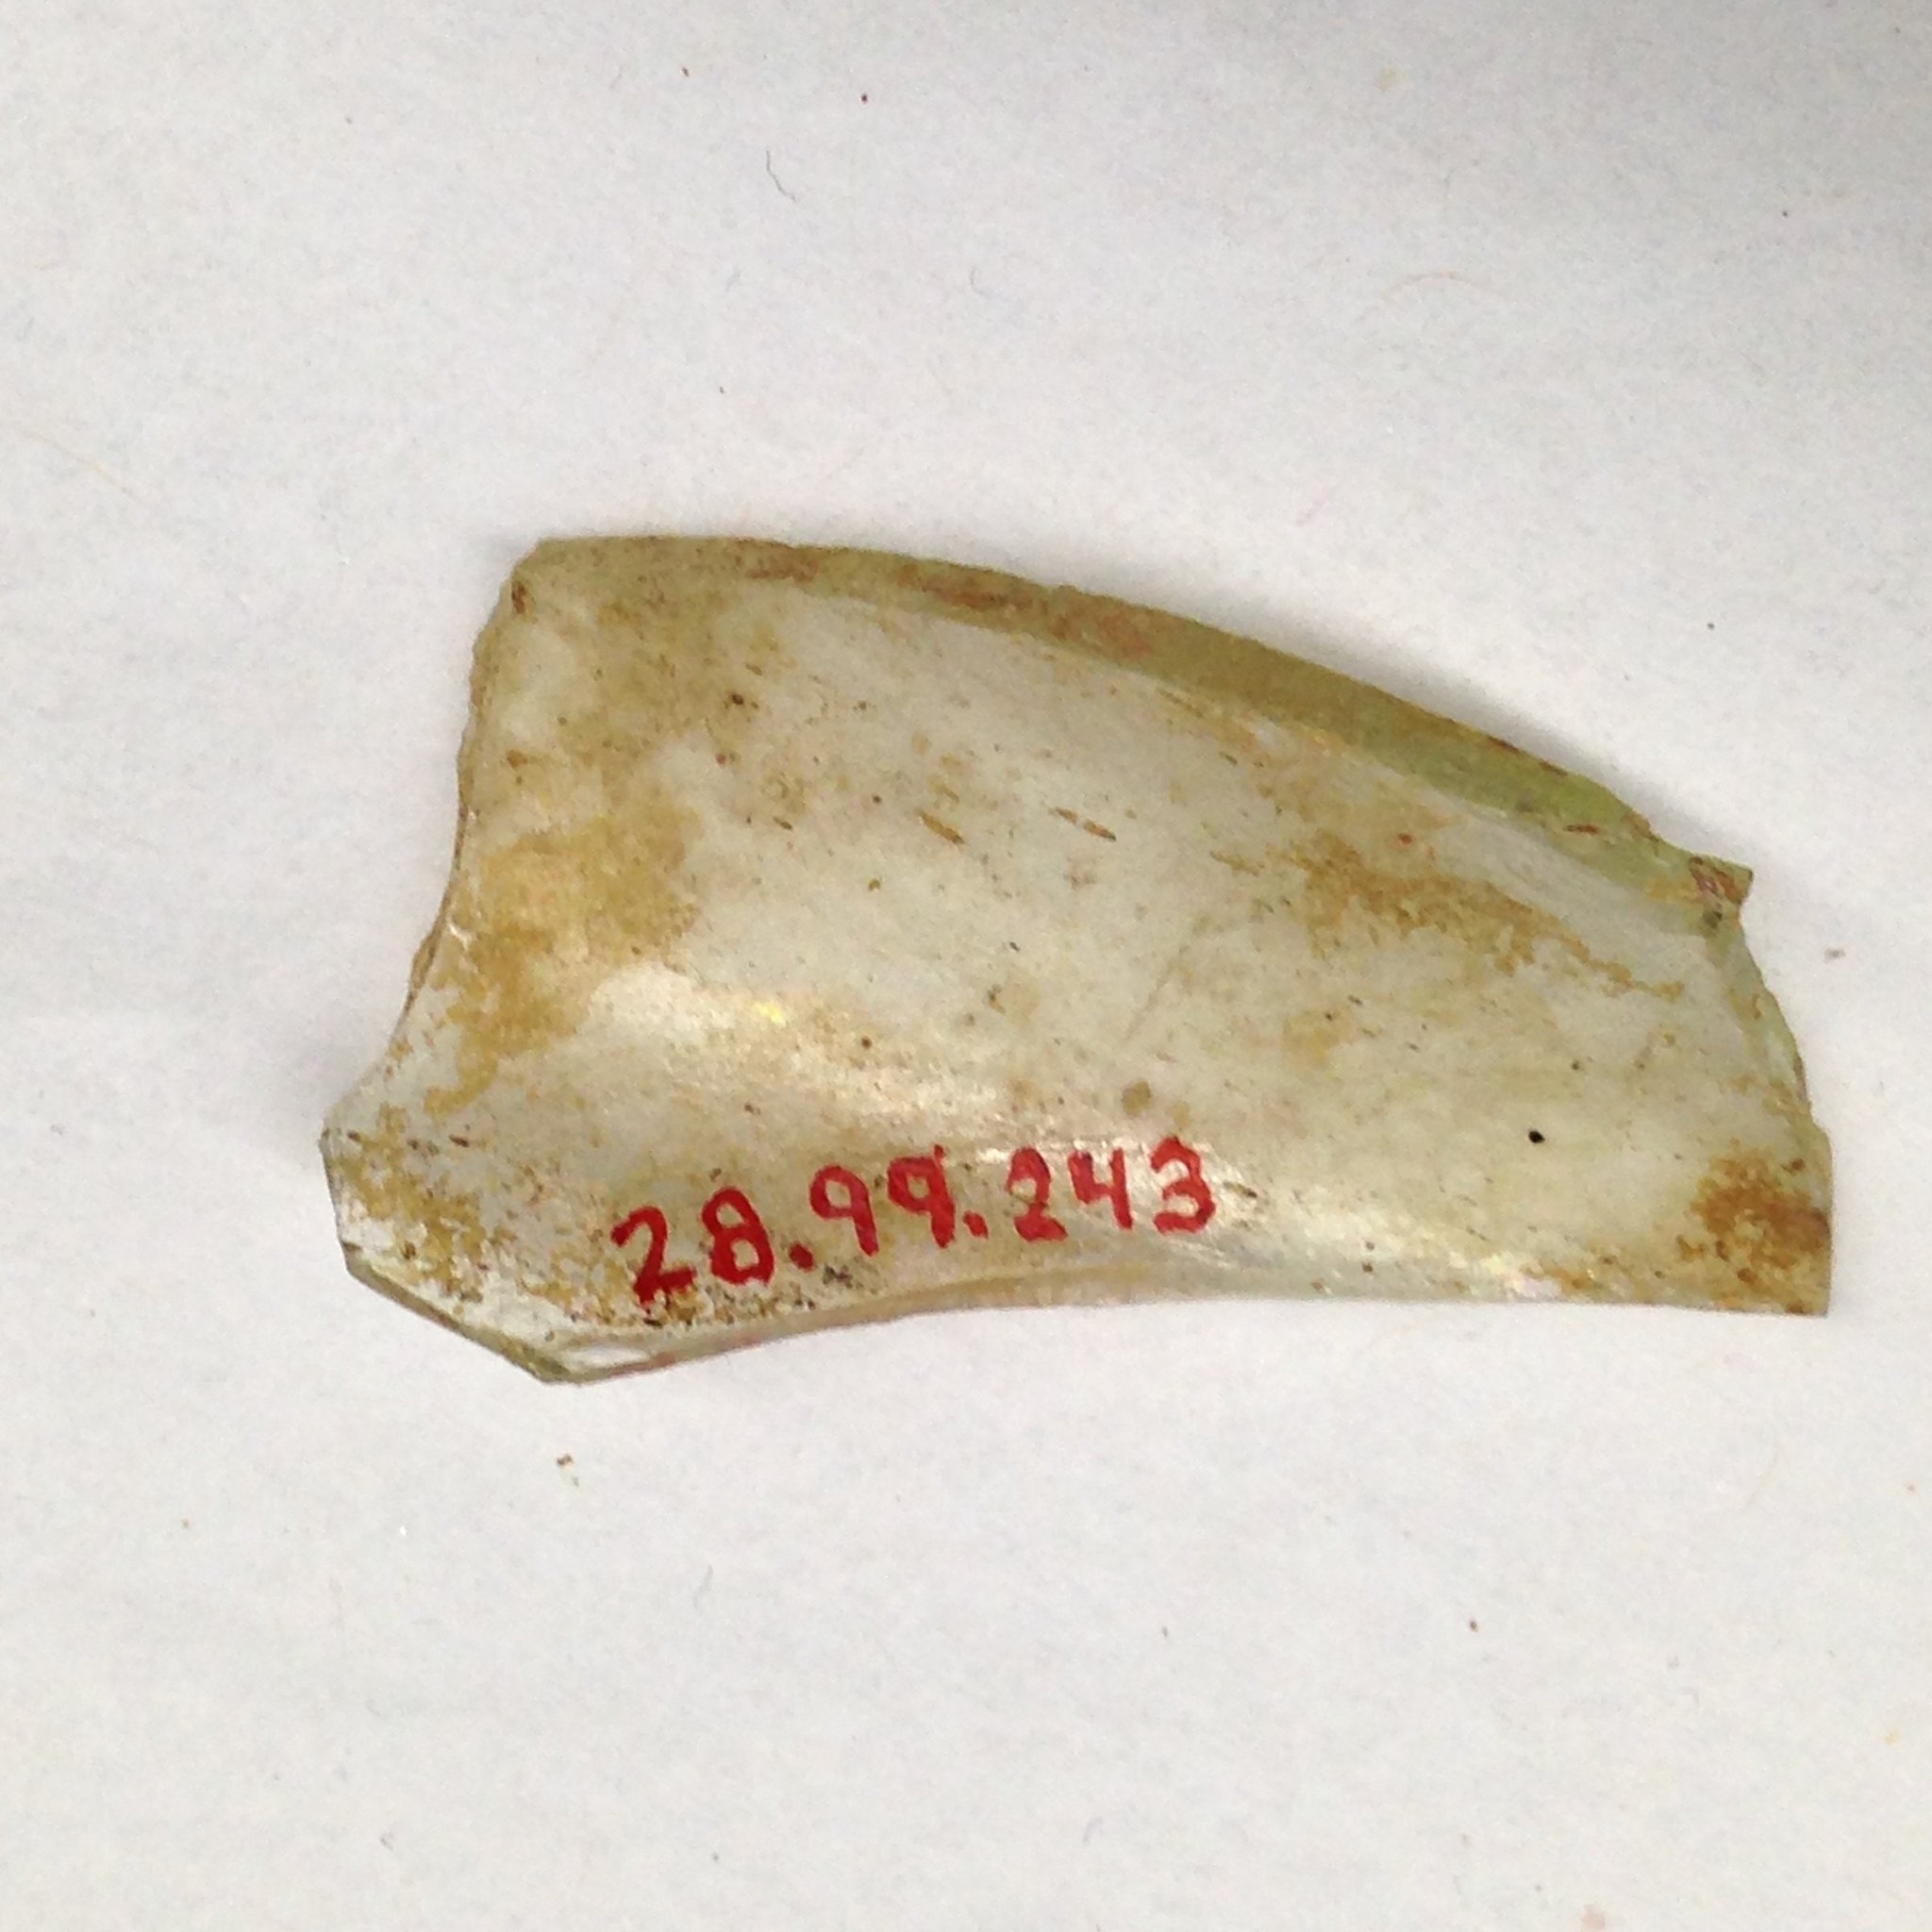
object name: fragment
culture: european or middle eastern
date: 1150-1250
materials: ceramic, glass